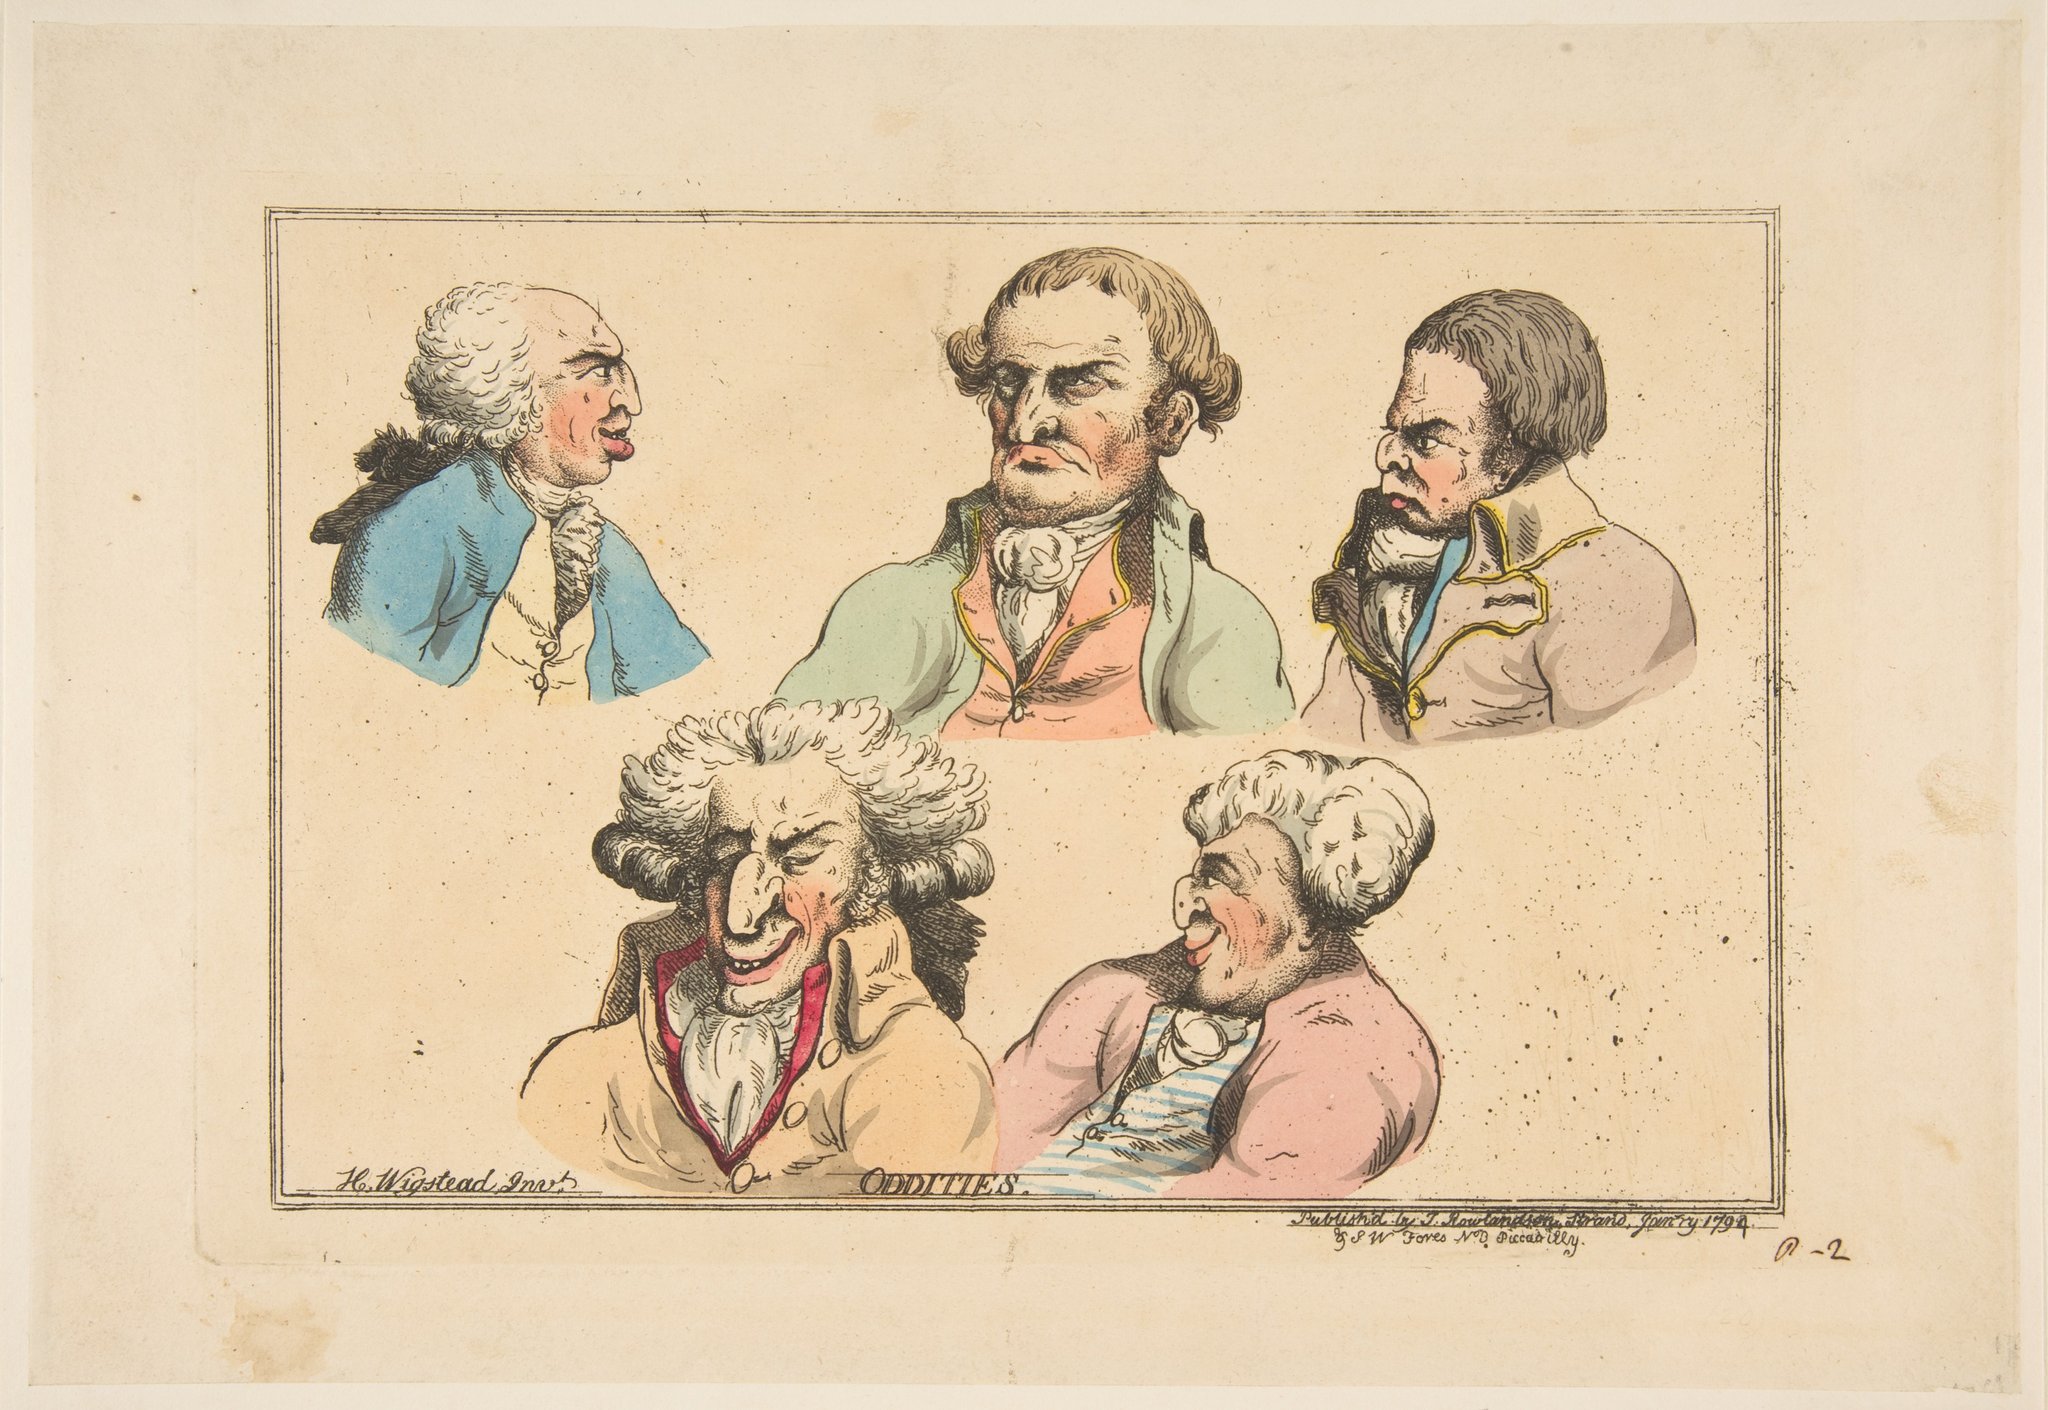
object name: print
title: Oddities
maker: thomas rowlandson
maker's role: artist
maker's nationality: british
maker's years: 1757-1827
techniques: etching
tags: men,caricature